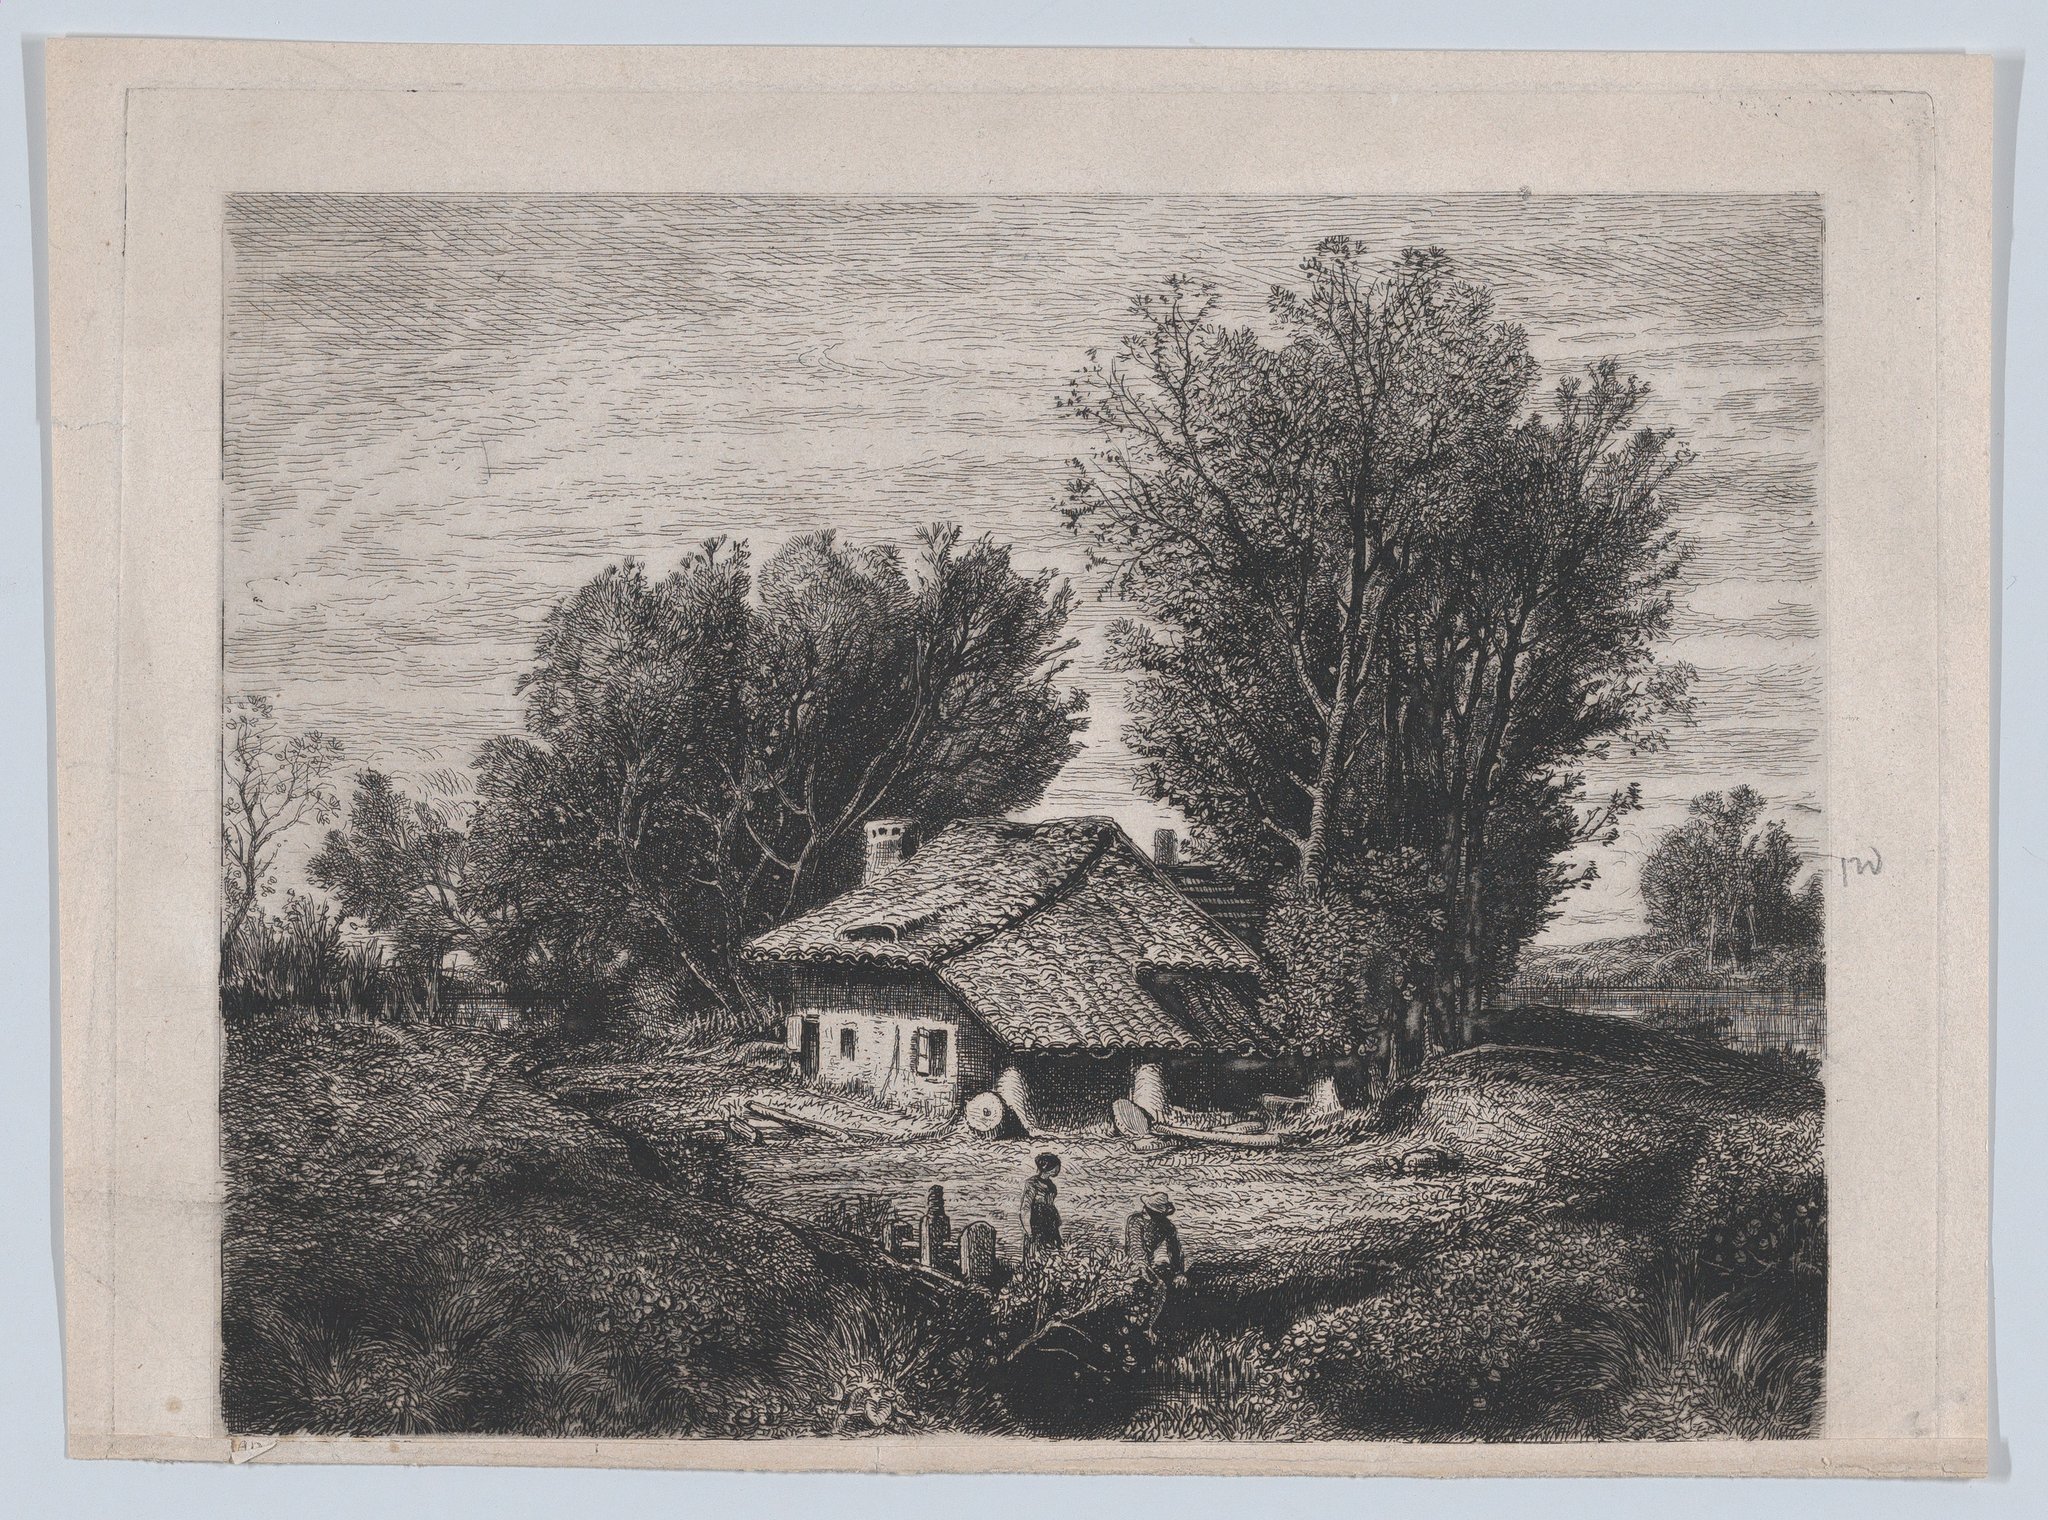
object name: print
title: Landscape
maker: adolphe balfourier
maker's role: artist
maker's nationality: french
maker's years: 1816-1876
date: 1862-1876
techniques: etching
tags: human figures,houses,landscapes,trees